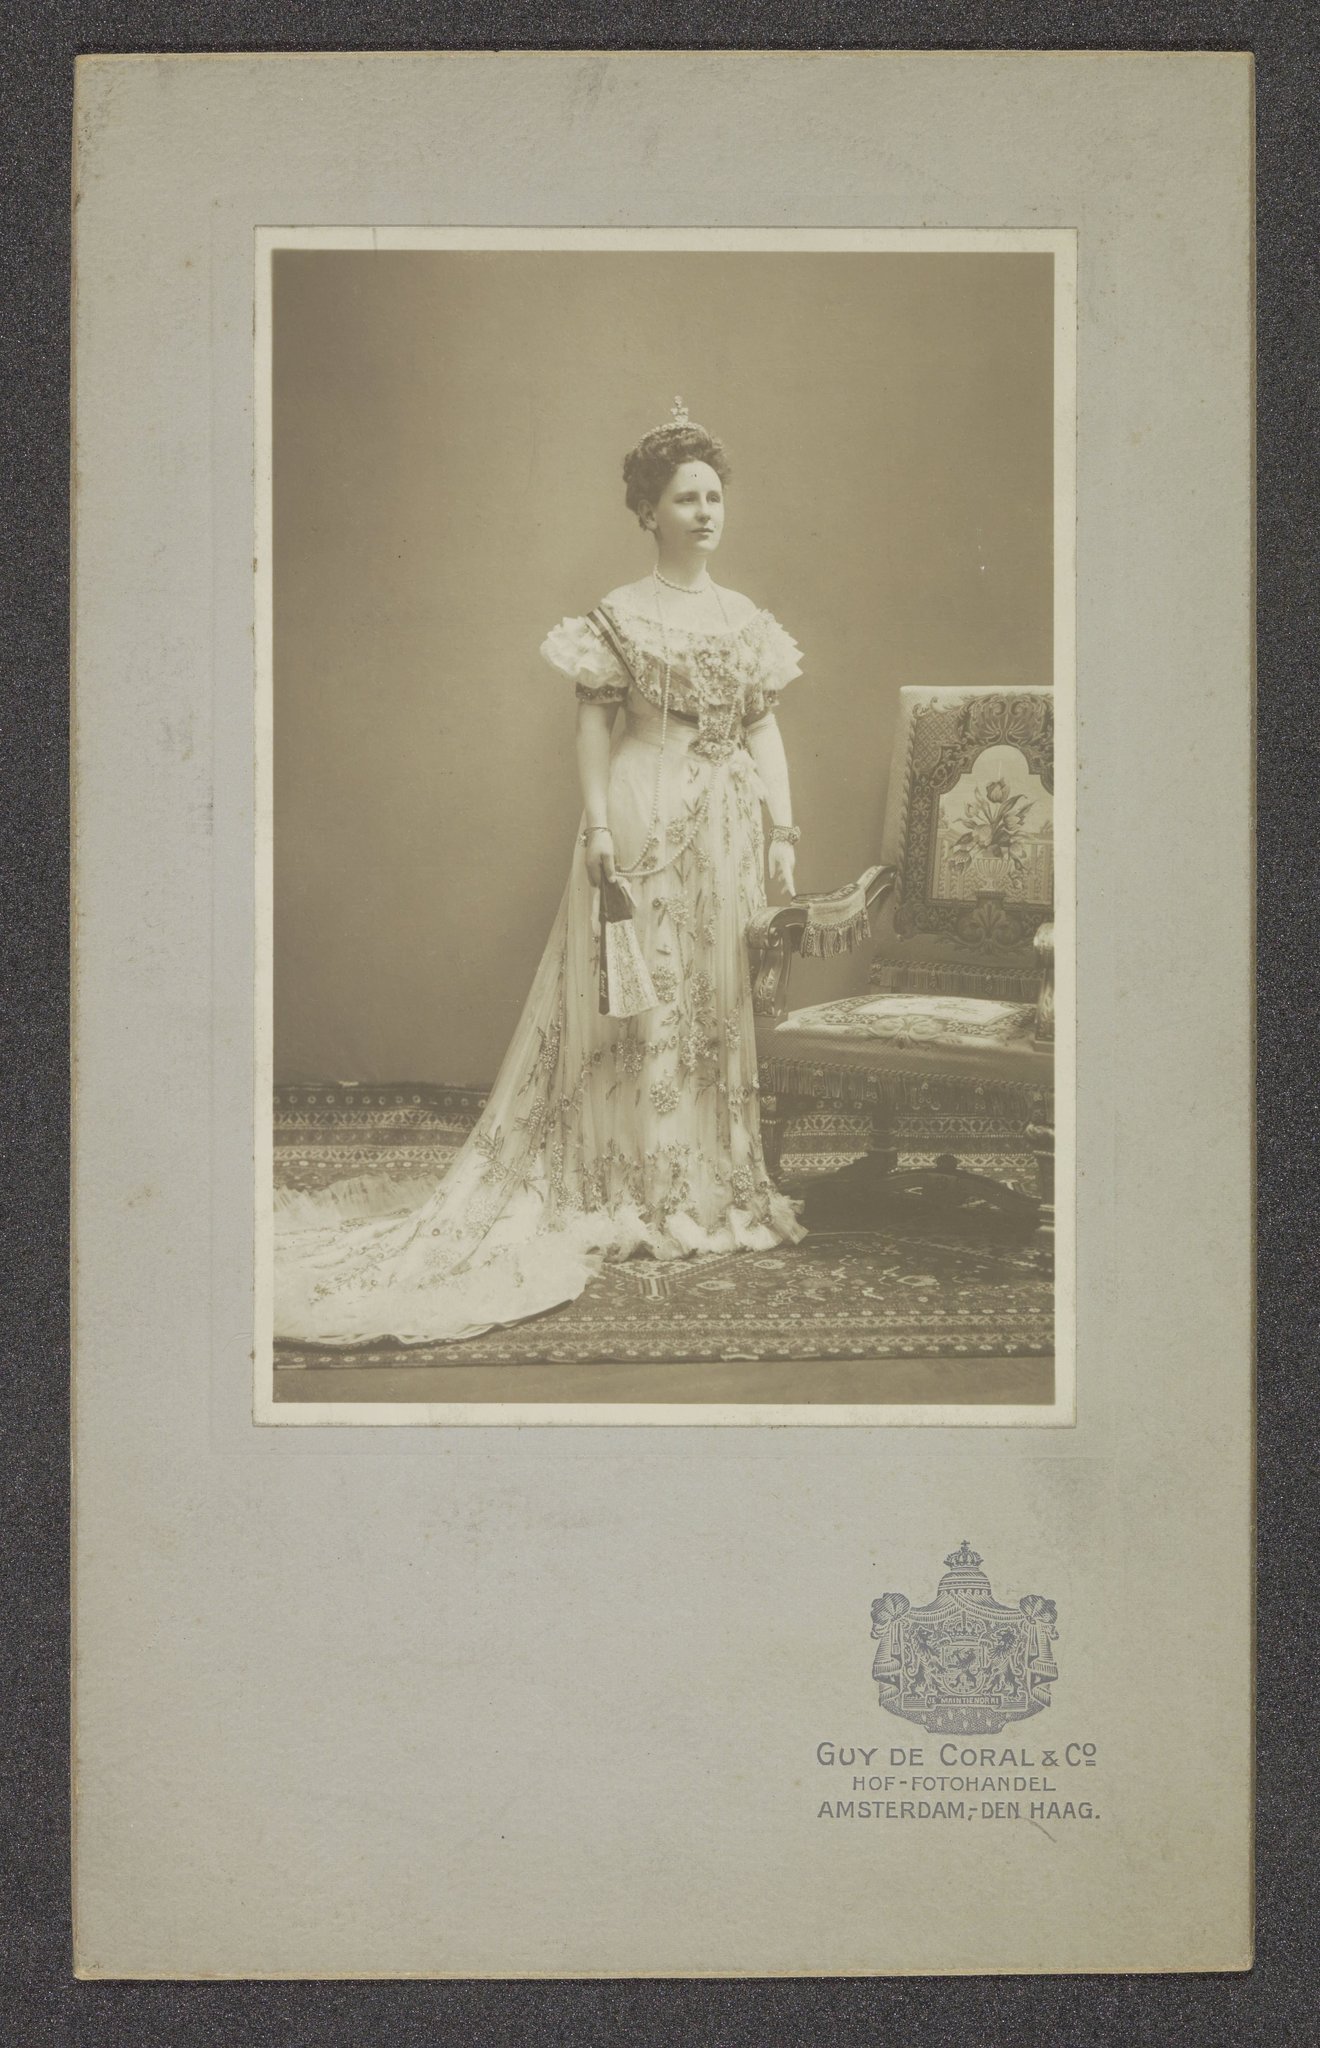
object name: photograph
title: Portret van jeugdige koningin Wilhelmina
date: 1895-1920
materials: cardboard, photographic support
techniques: gelatin silver print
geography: the hague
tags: the hague, print maker, wilhelmina of the netherlands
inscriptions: inscription: ‘foto niet in den handel, bureau steun comite Zwolle 1915’